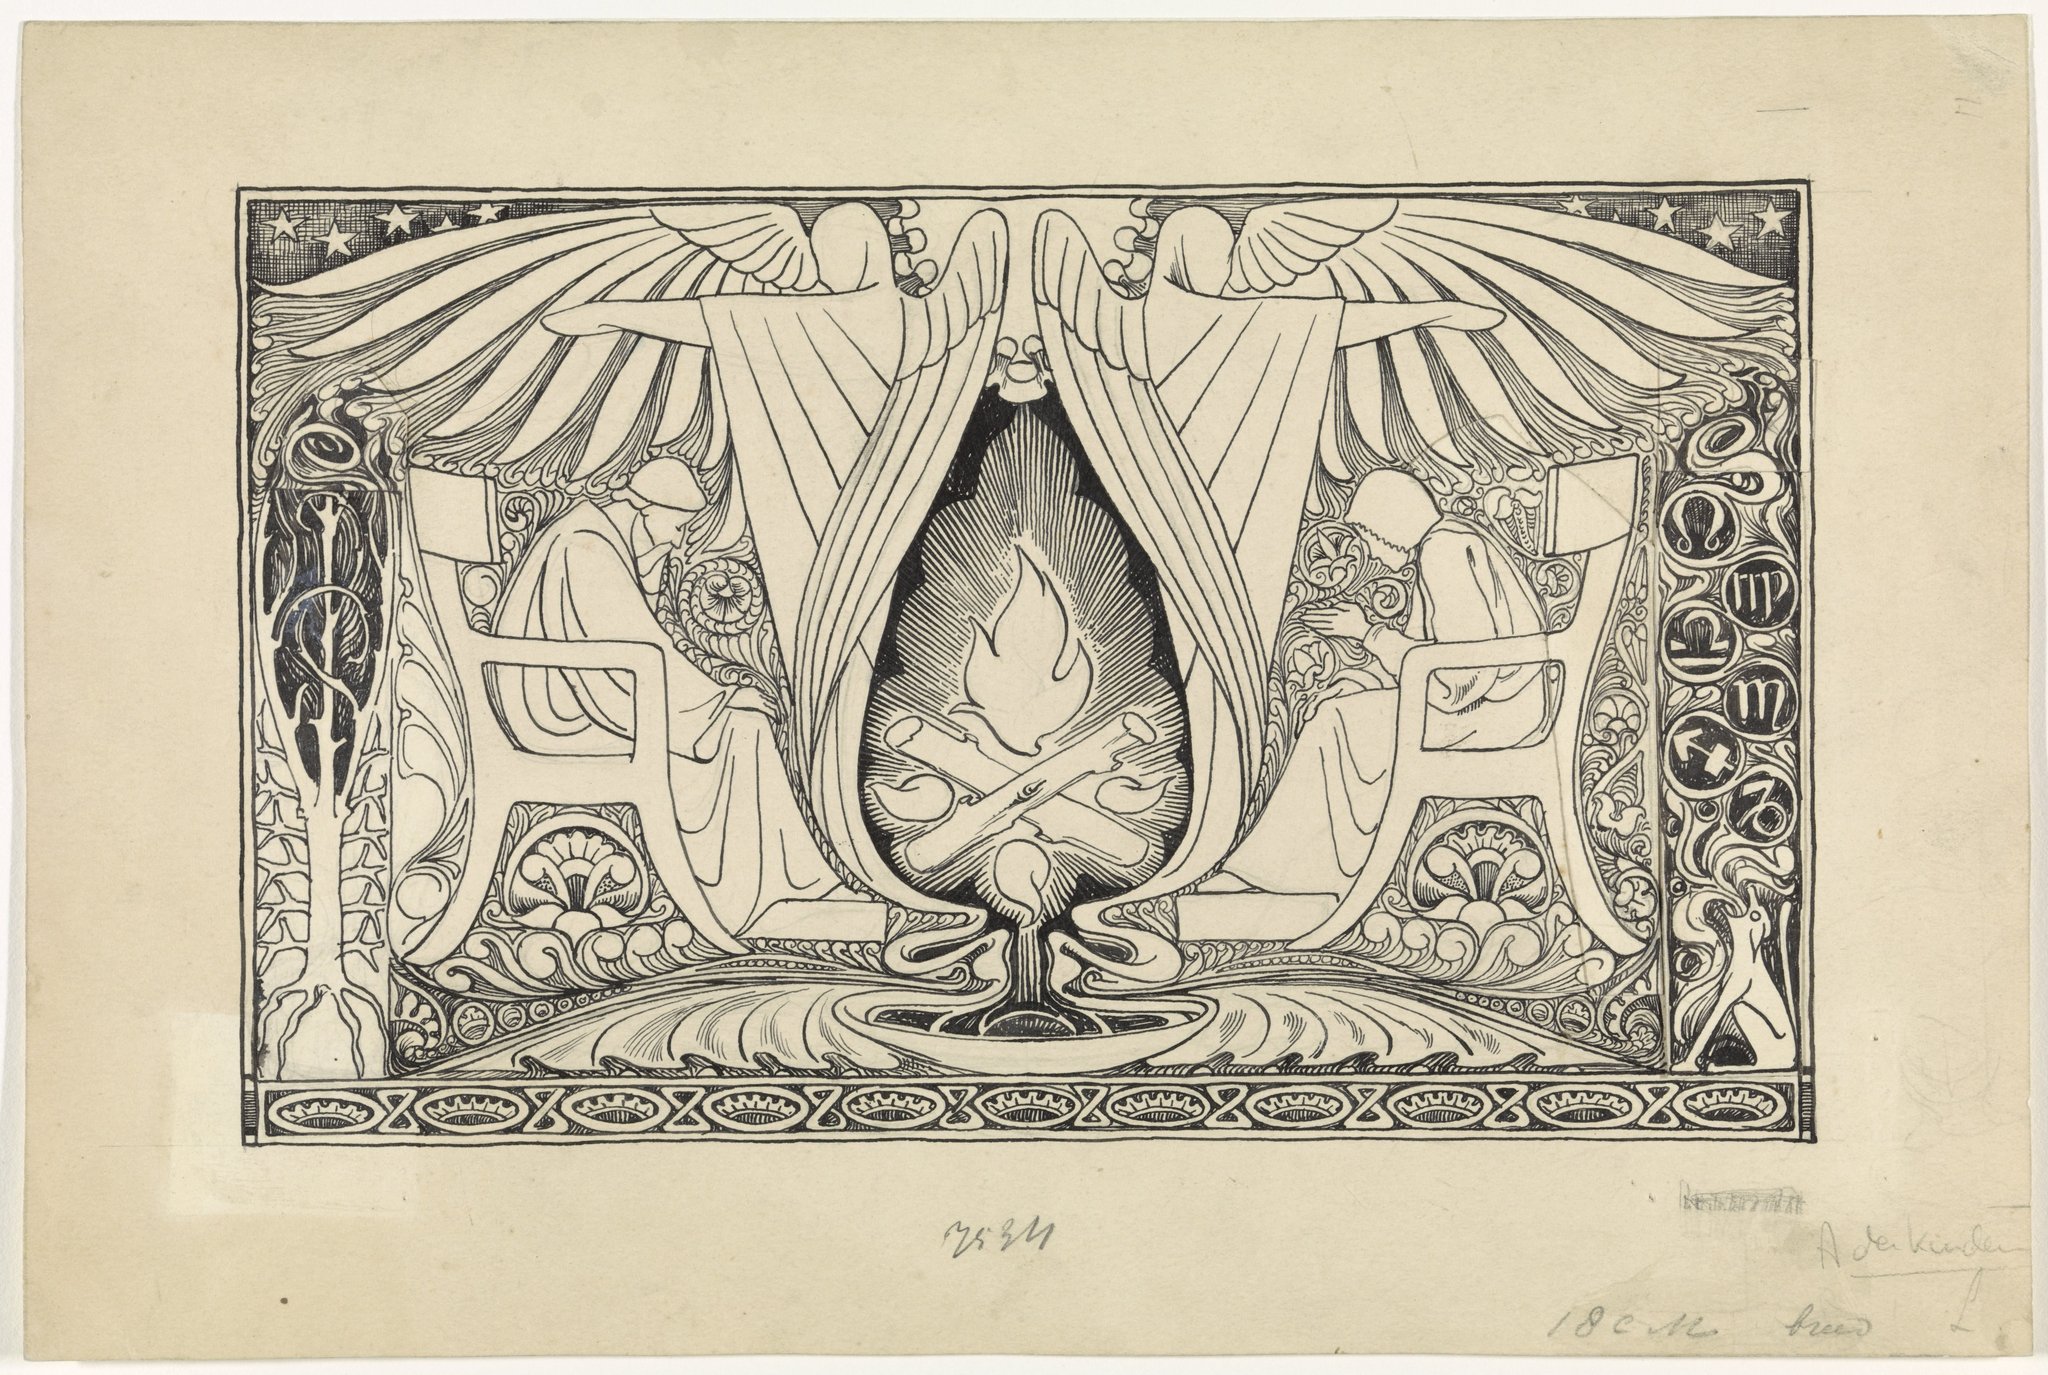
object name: drawing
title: Ornamentale voorstelling van man en vrouw aan weerszijden van een haardvuur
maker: antoon derkinderen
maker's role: draughtsman, painter, print maker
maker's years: 1859-1925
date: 1869-1925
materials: ink, paper, pencil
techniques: pen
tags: warming oneself at a fire (or hearth, stove, fire-pan, brazier)